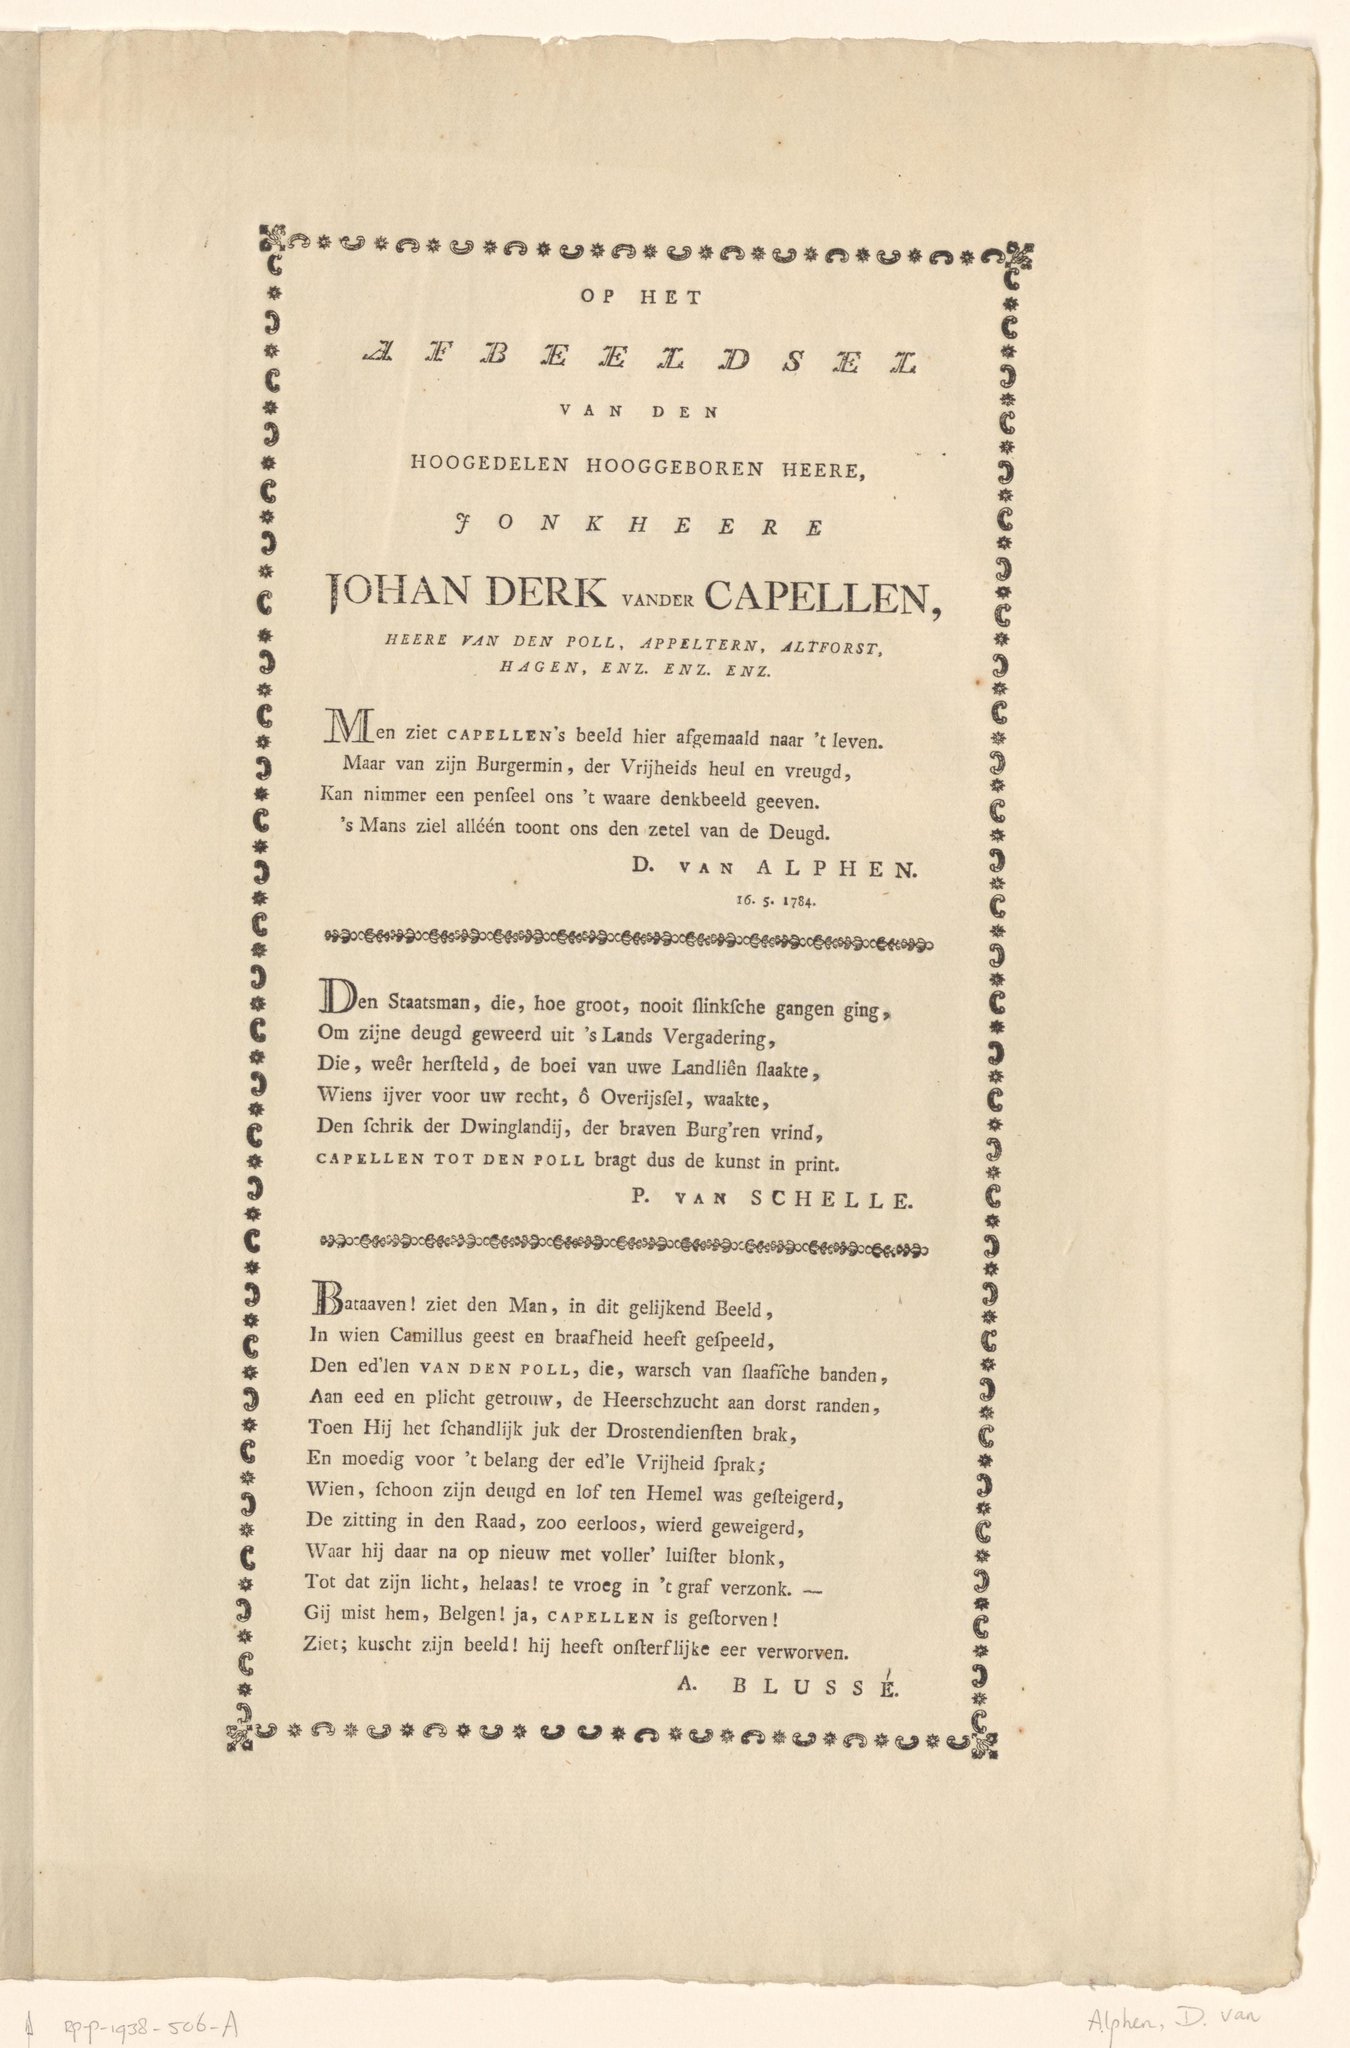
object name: text sheet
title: Vier lofdichten op de politicus Joan Derk van der Capellen tot den Pol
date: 1785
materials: paper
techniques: letterpress printing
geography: leiden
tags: politician, joan derk van der capellen tot den pol, historical persons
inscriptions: date